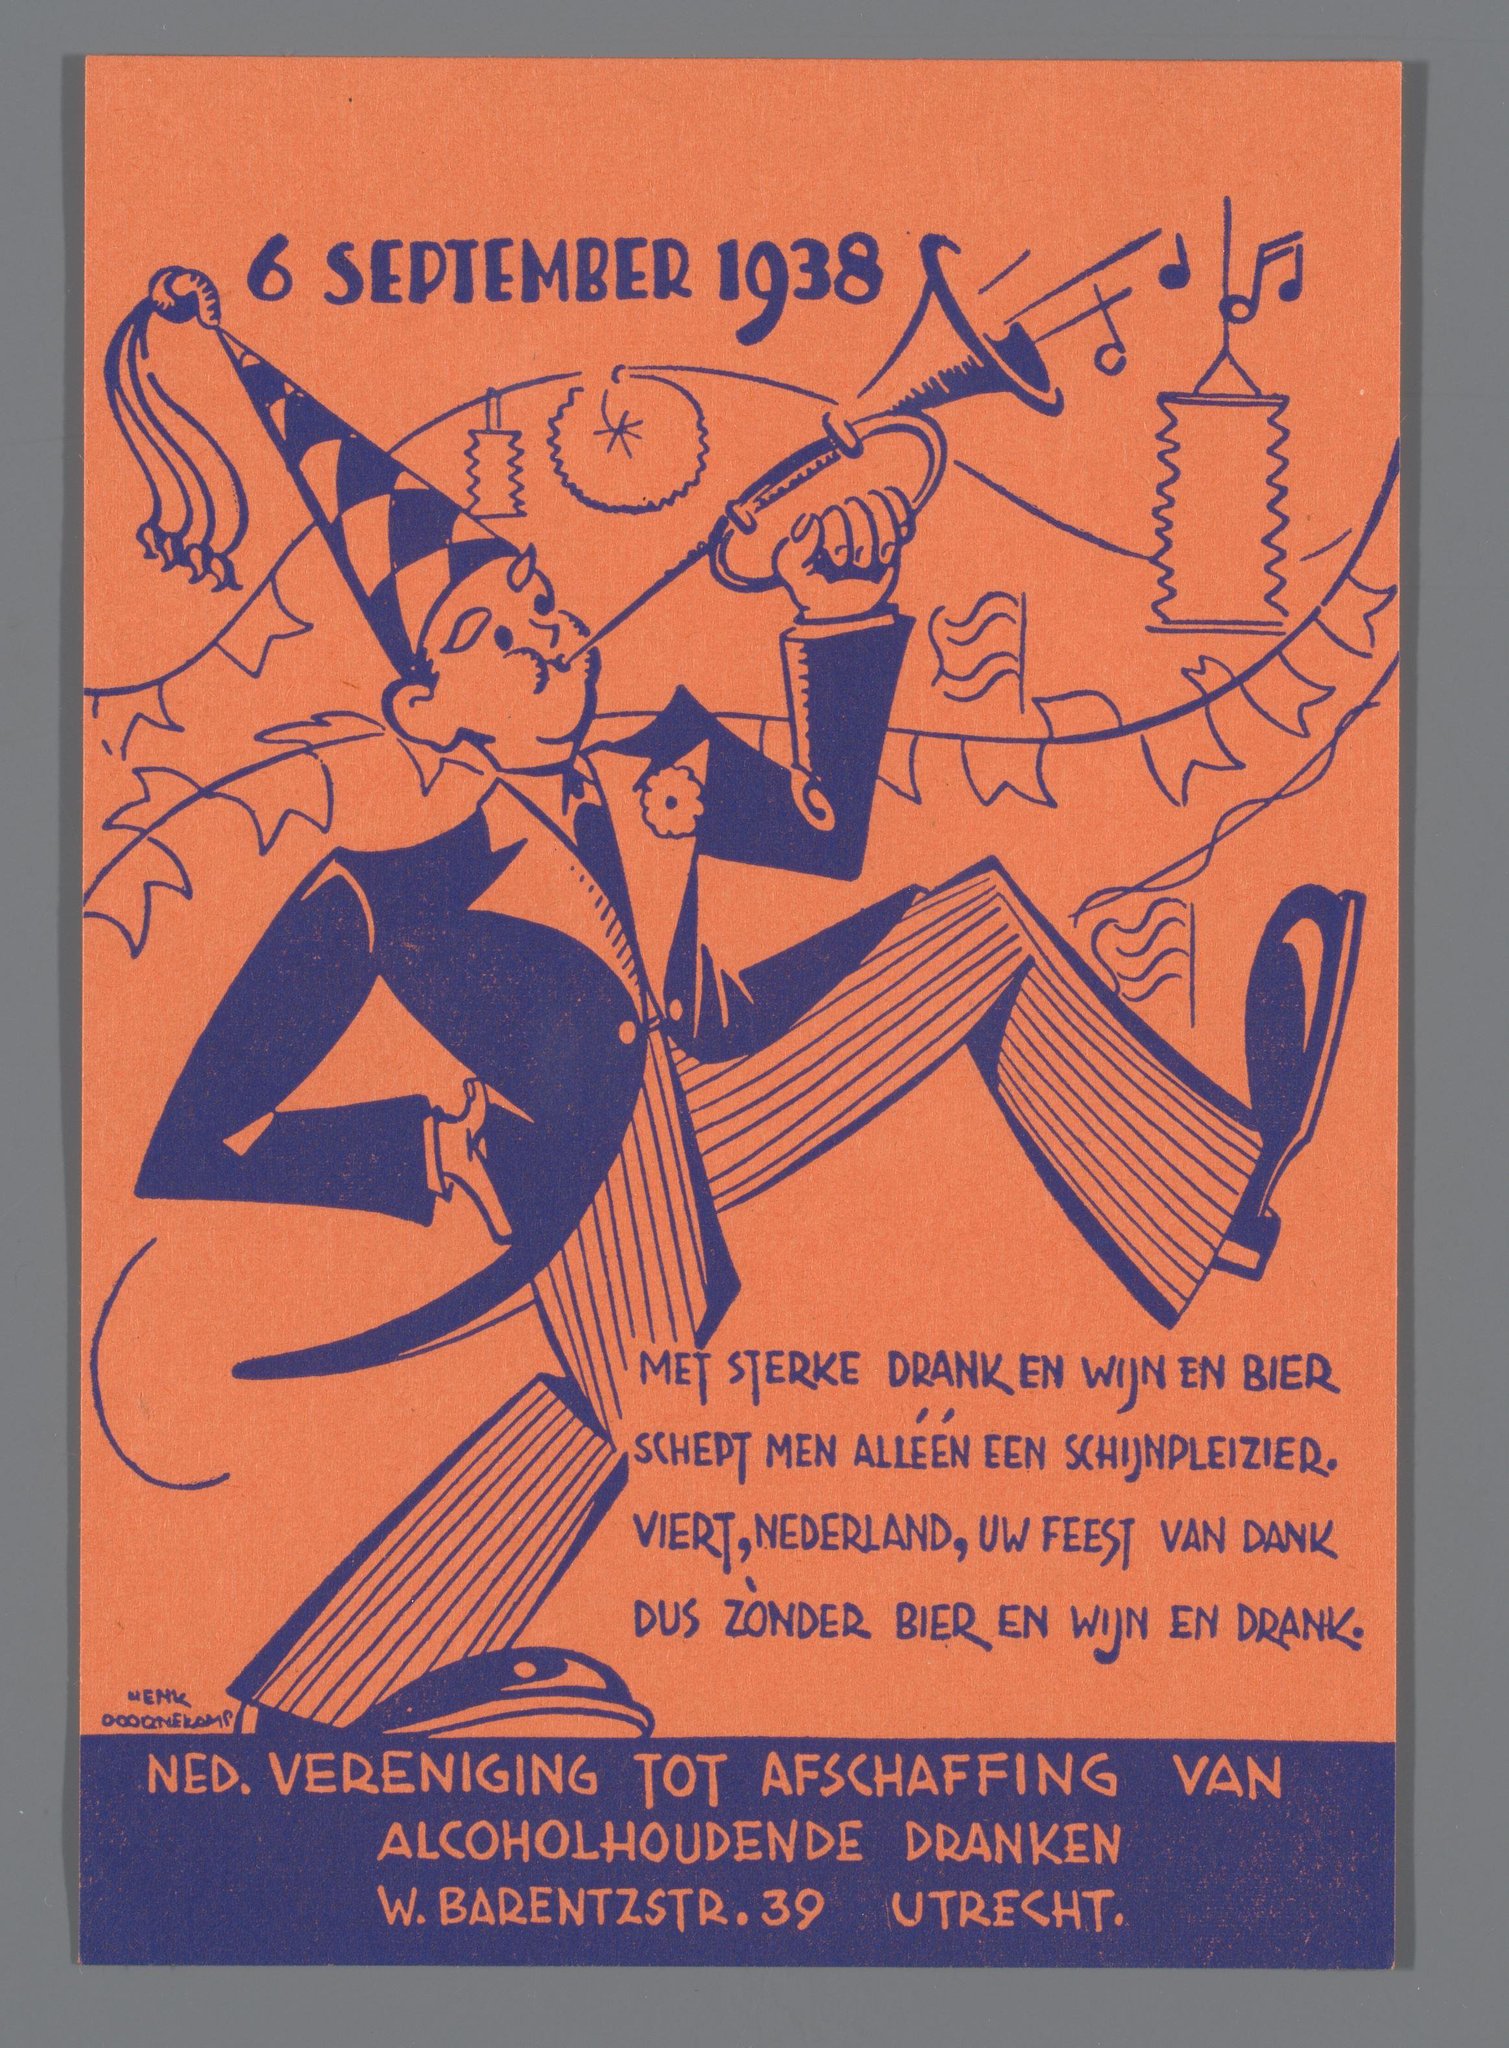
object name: gelegenheidsdrukwerk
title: 6 september 1938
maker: henk doornekamp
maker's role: schrijver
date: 1938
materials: paper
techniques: printing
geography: utrecht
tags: the hague, wilhelmina of the netherlands, netherlands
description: Drukwerk, uitgegeven ter gelegenheid van het 40 jarig regeringsjubileum van Koningin Wilhelmina in 1938, oranjekleurig papier, eenzijdig bedrukt in blauw, feestvierend figuur naar rechts.